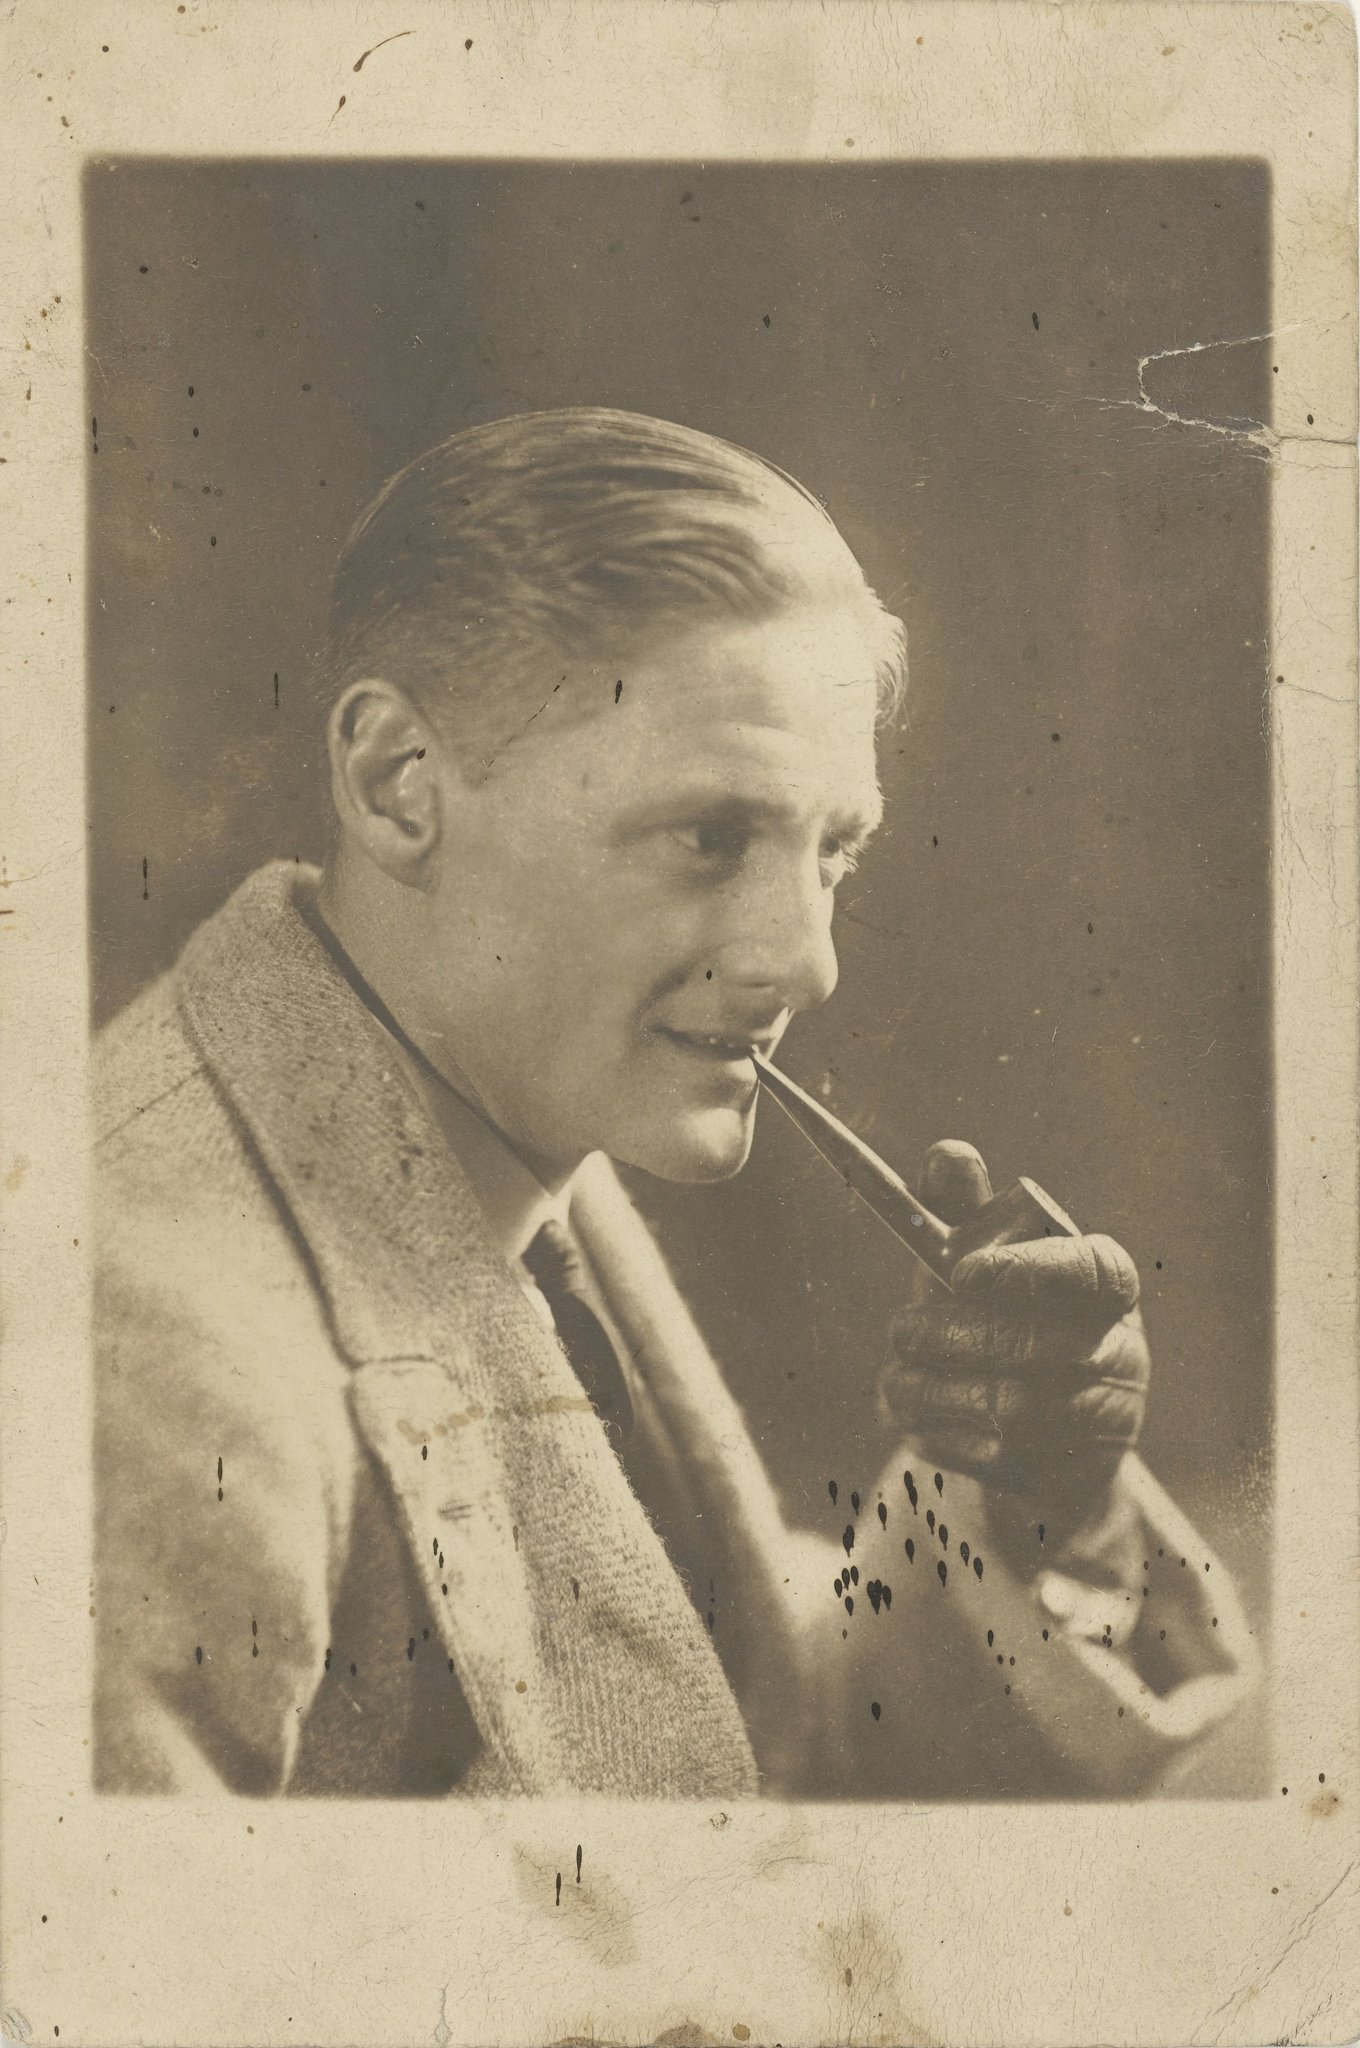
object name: photograph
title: Portret van Grub Vermeulen met pijp in de mond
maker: Anonymous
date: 1918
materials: cardboard, photographic support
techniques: gelatin silver print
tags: chest, bust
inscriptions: inscription: ‘Grub Vermeulen’